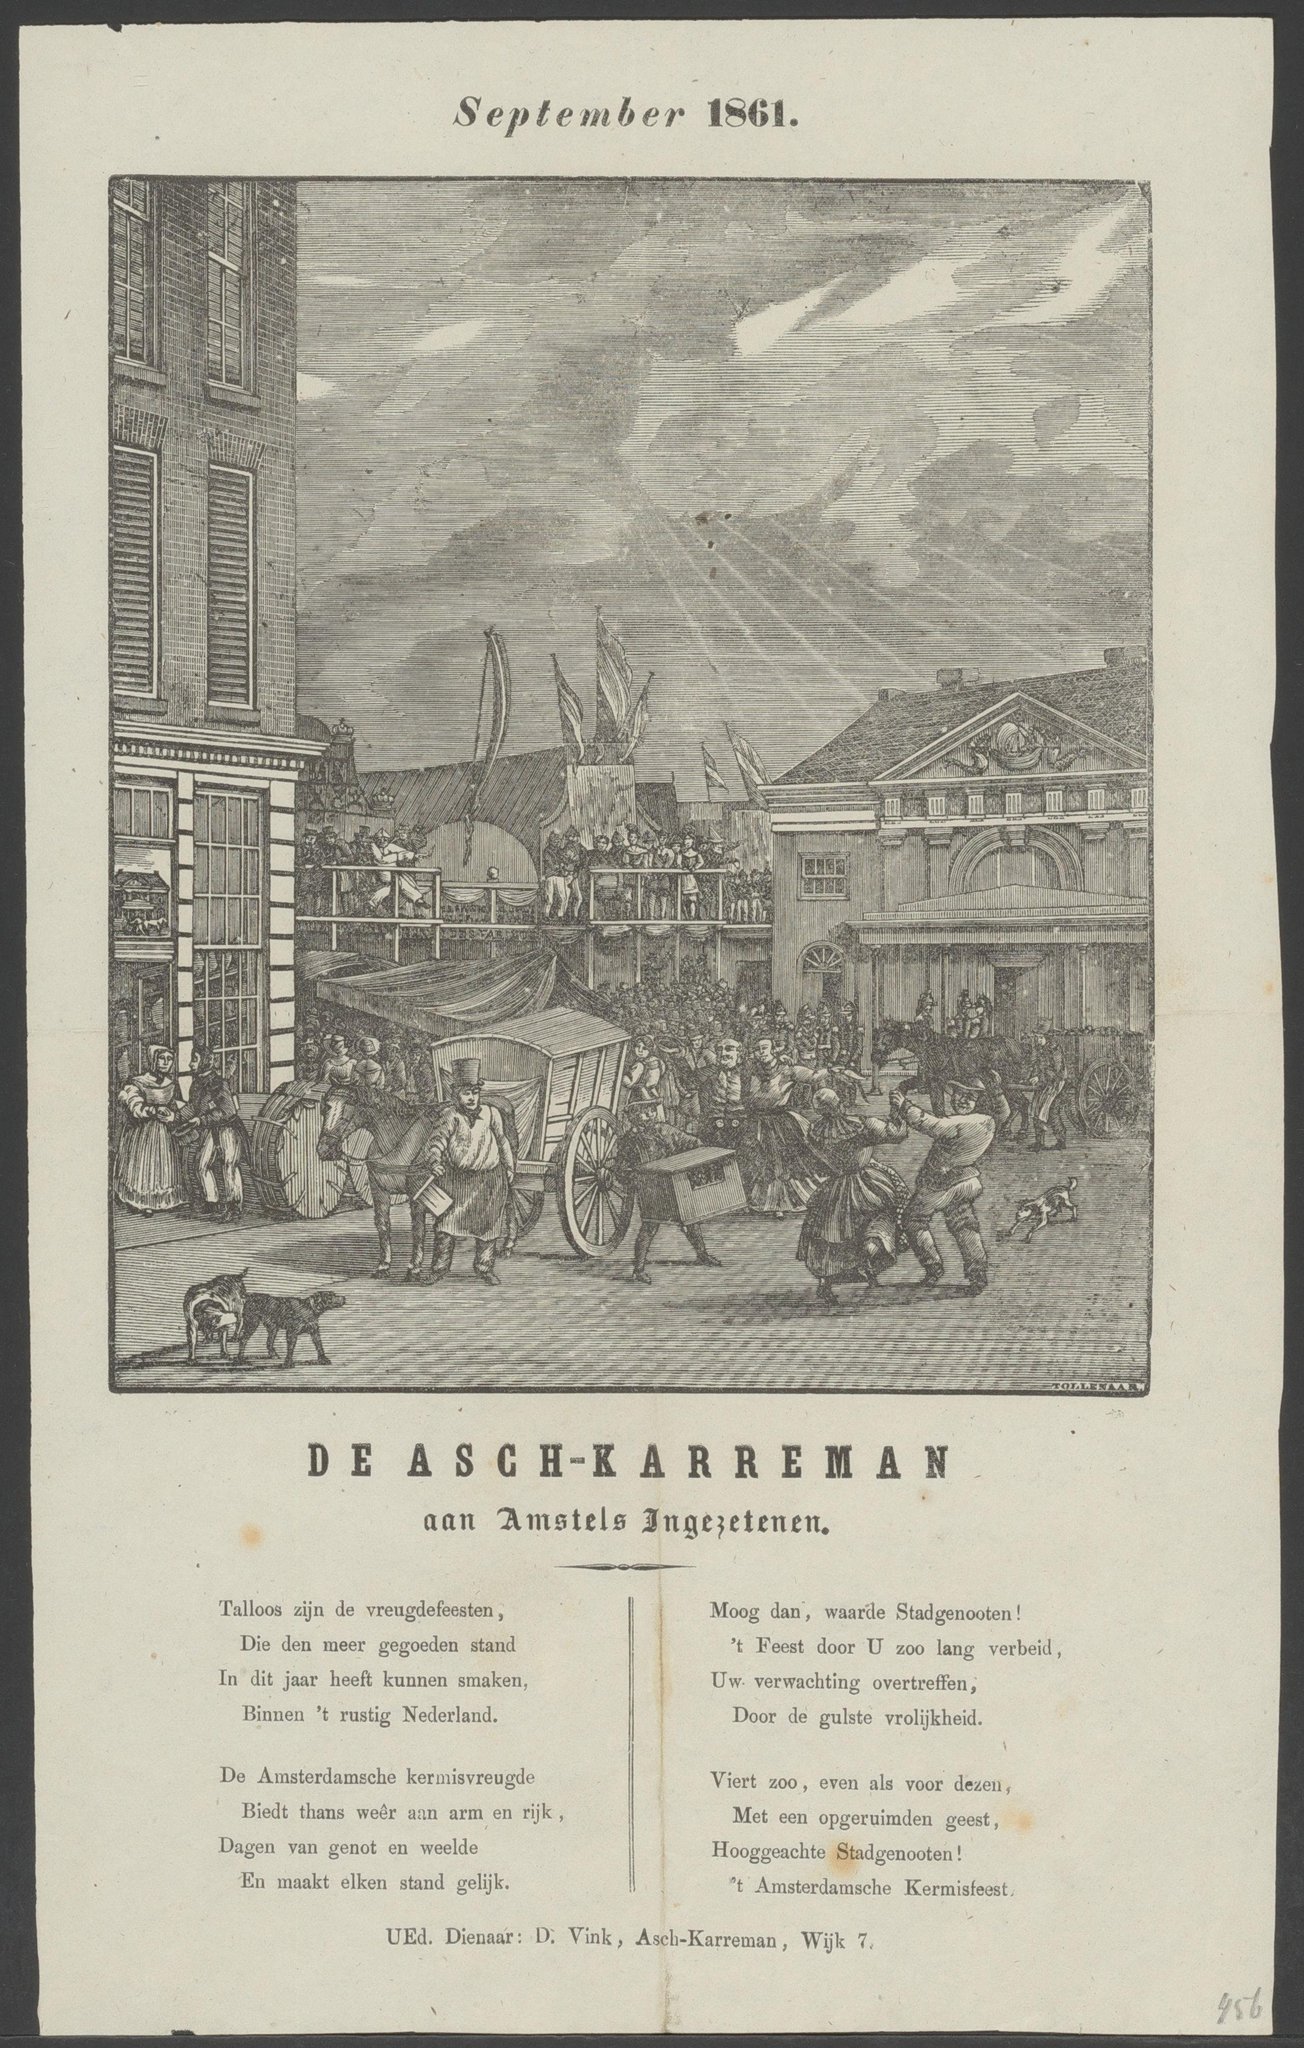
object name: fair print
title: Kermisprent van de Amsterdamse askarrenmannen voor het jaar 1861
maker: dirk wijbrand tollenaar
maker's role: print maker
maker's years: 1808-1858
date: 1861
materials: paper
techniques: letterpress printing, engraving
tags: pleasure fair and circus, garbage collection, amsterdam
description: Kermisprent namens de askarrenmannen (karrenman of vuilnisman) te Amsterdam, september 1861. Gezicht op de kermis op de Botermarkt met de Regulierswaag. Op de markt twee vuilniskarren. Onderaan een gedicht in twee kolommen. Namens D. Vink, de askarreman van wijk no. 7. Onderwerpsrubrieken binnen de Atlas Zeden en Gewoonten: Zeden en gewoonten in engeren zin, Volksleven, Volksbladen, Nieuwjaars- en Kerstwenschen, Amsterdam.